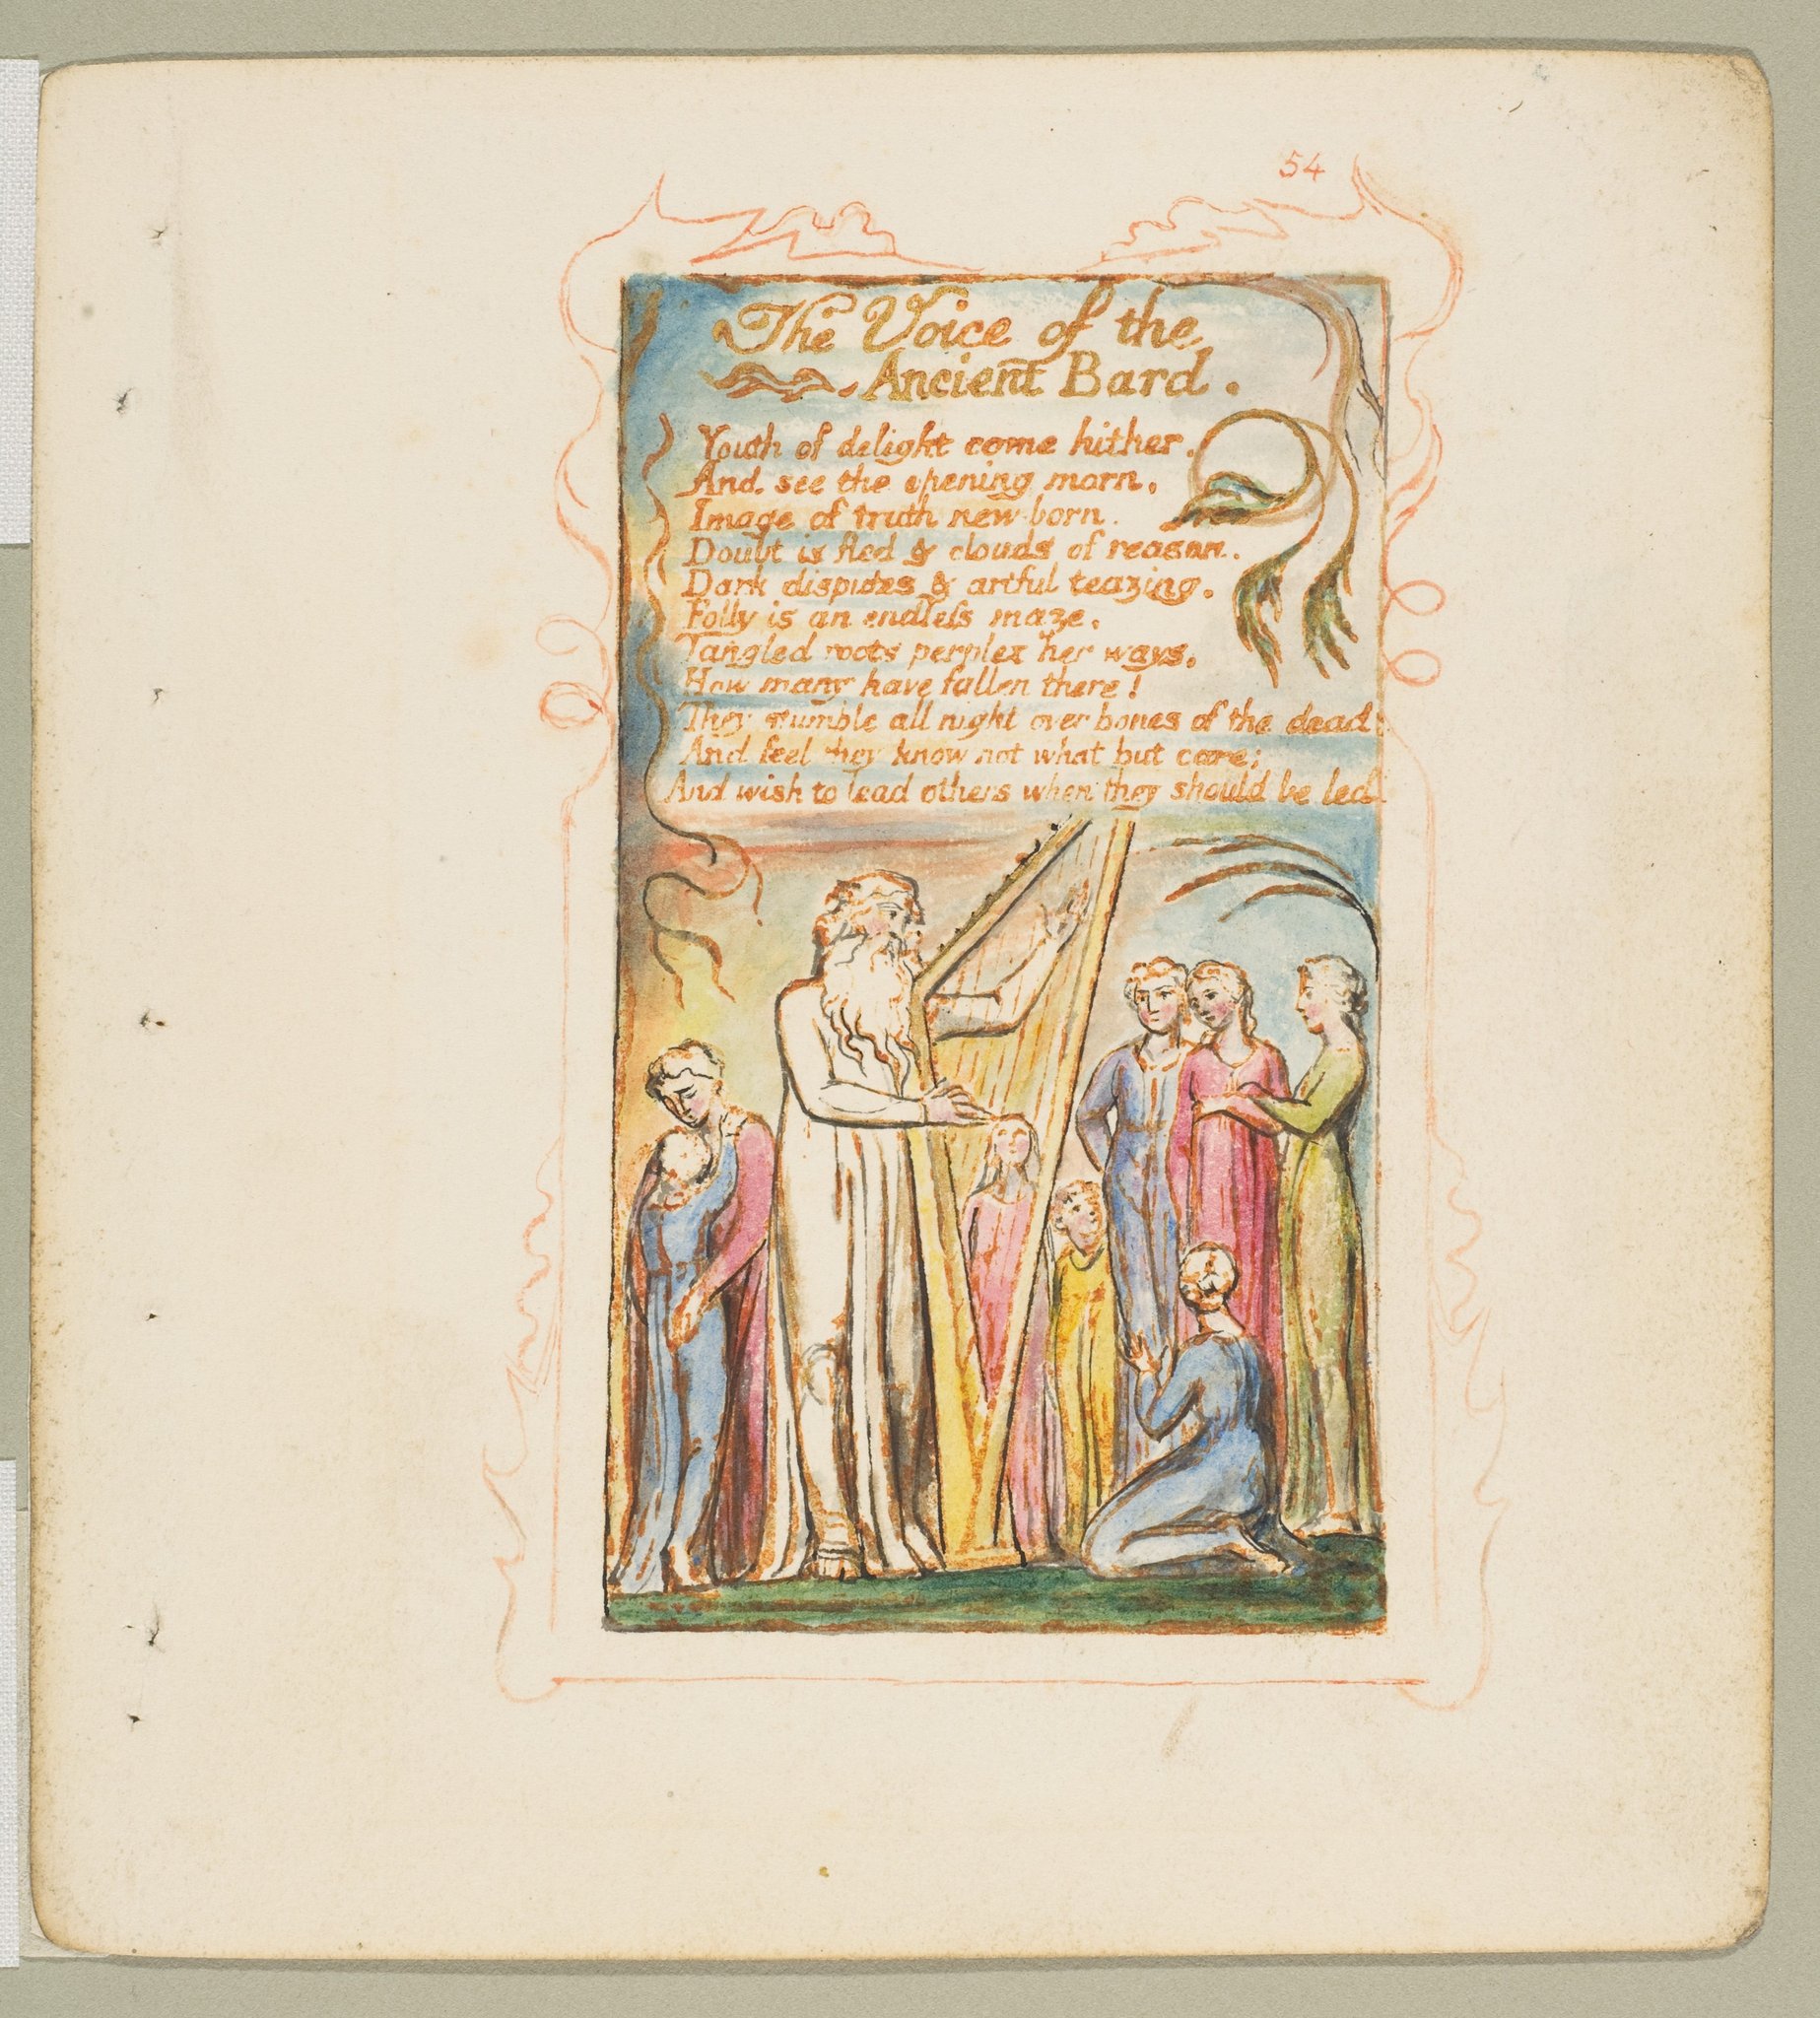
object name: print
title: Songs of Experience: The Voice of the Ancient Bard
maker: william blake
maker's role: artist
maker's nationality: british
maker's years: 1757-1827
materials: gold, ink, shell, watercolor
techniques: etching, hand coloring, printing, relief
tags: musical instruments,poetry,women